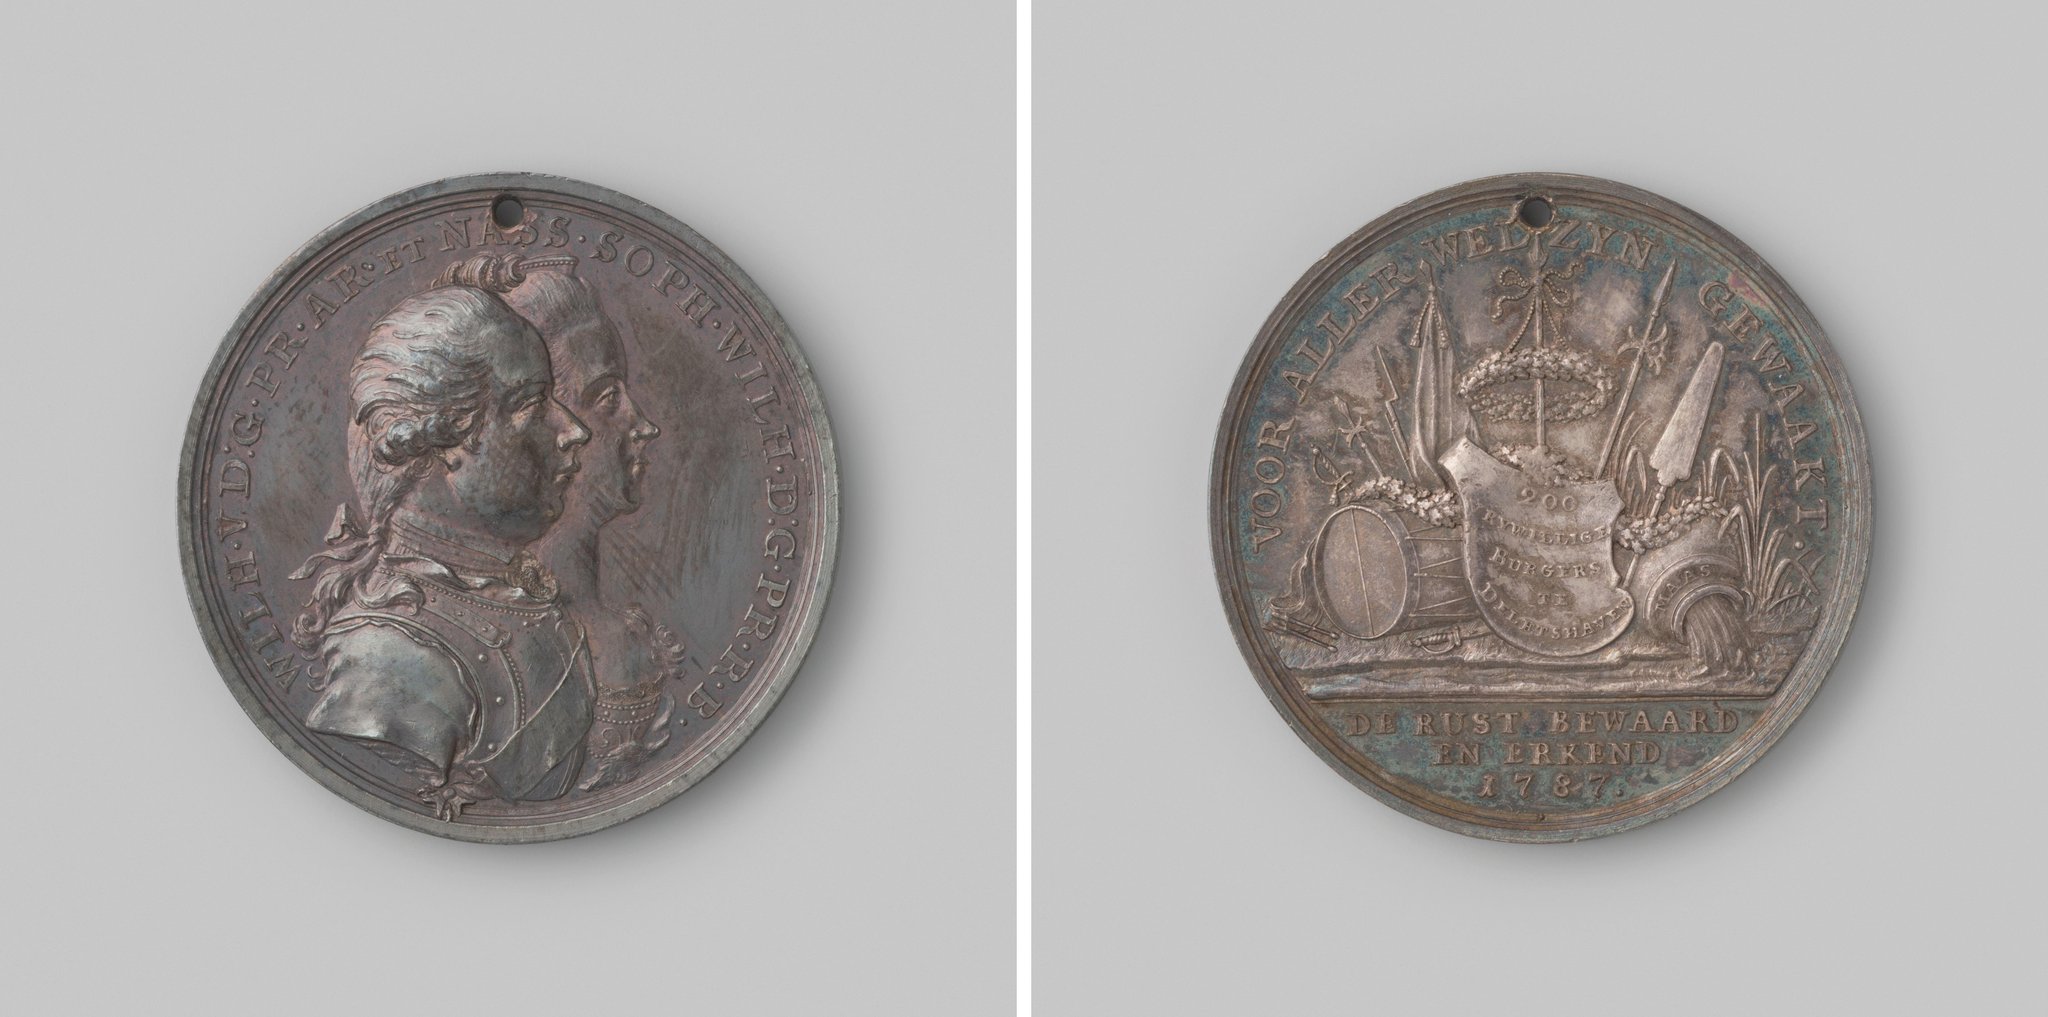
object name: history medal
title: Op het beschermen van Delfshaven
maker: Anonymous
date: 1787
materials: cardboard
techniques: gilding